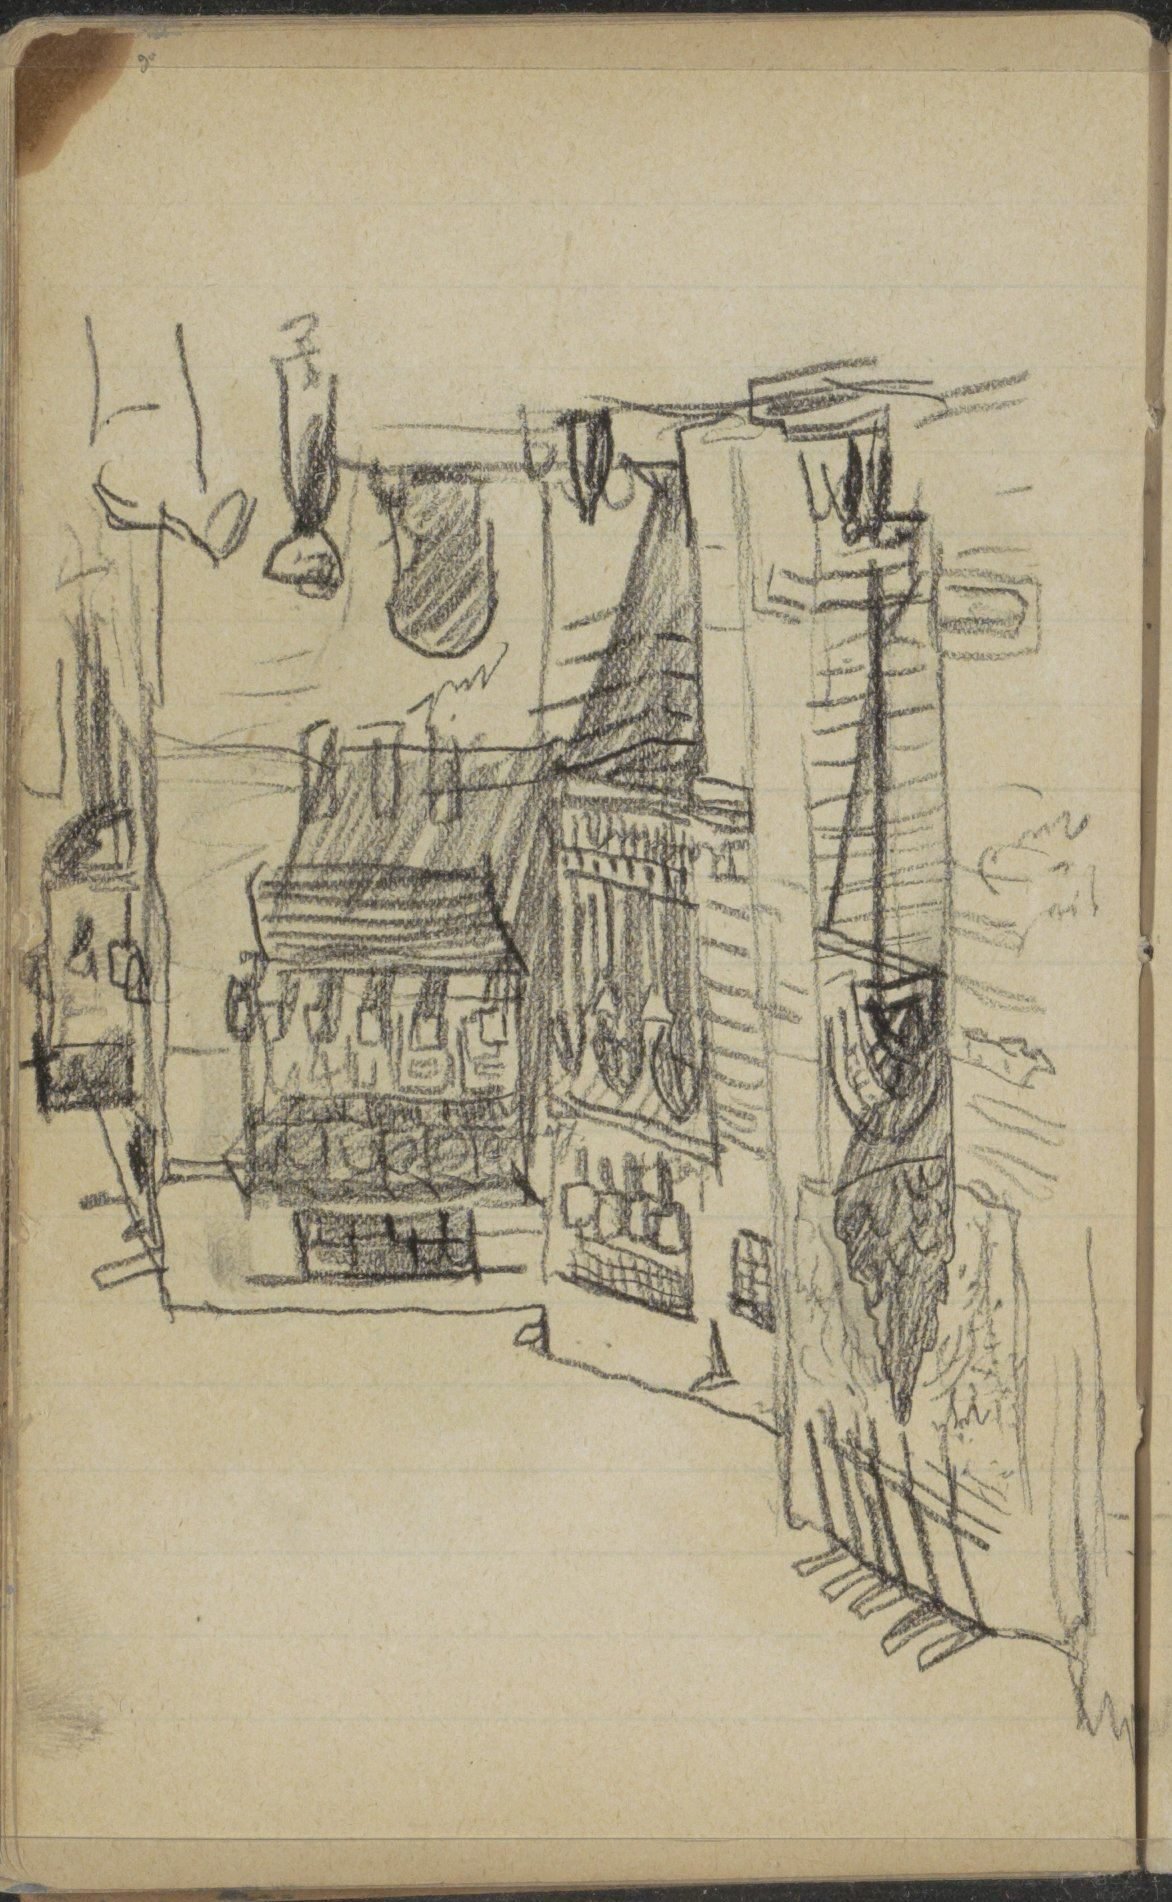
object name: sketchbook leaf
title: Straat in Caïro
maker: marius bauer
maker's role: draughtsman, print maker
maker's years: 1867-1932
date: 1894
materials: chalk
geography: cairo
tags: street (+ city(-scape) with figures, staffage)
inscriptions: kleurnotitie, handgeschreven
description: Pagina 90 uit een schetsboek met 48 bladen.